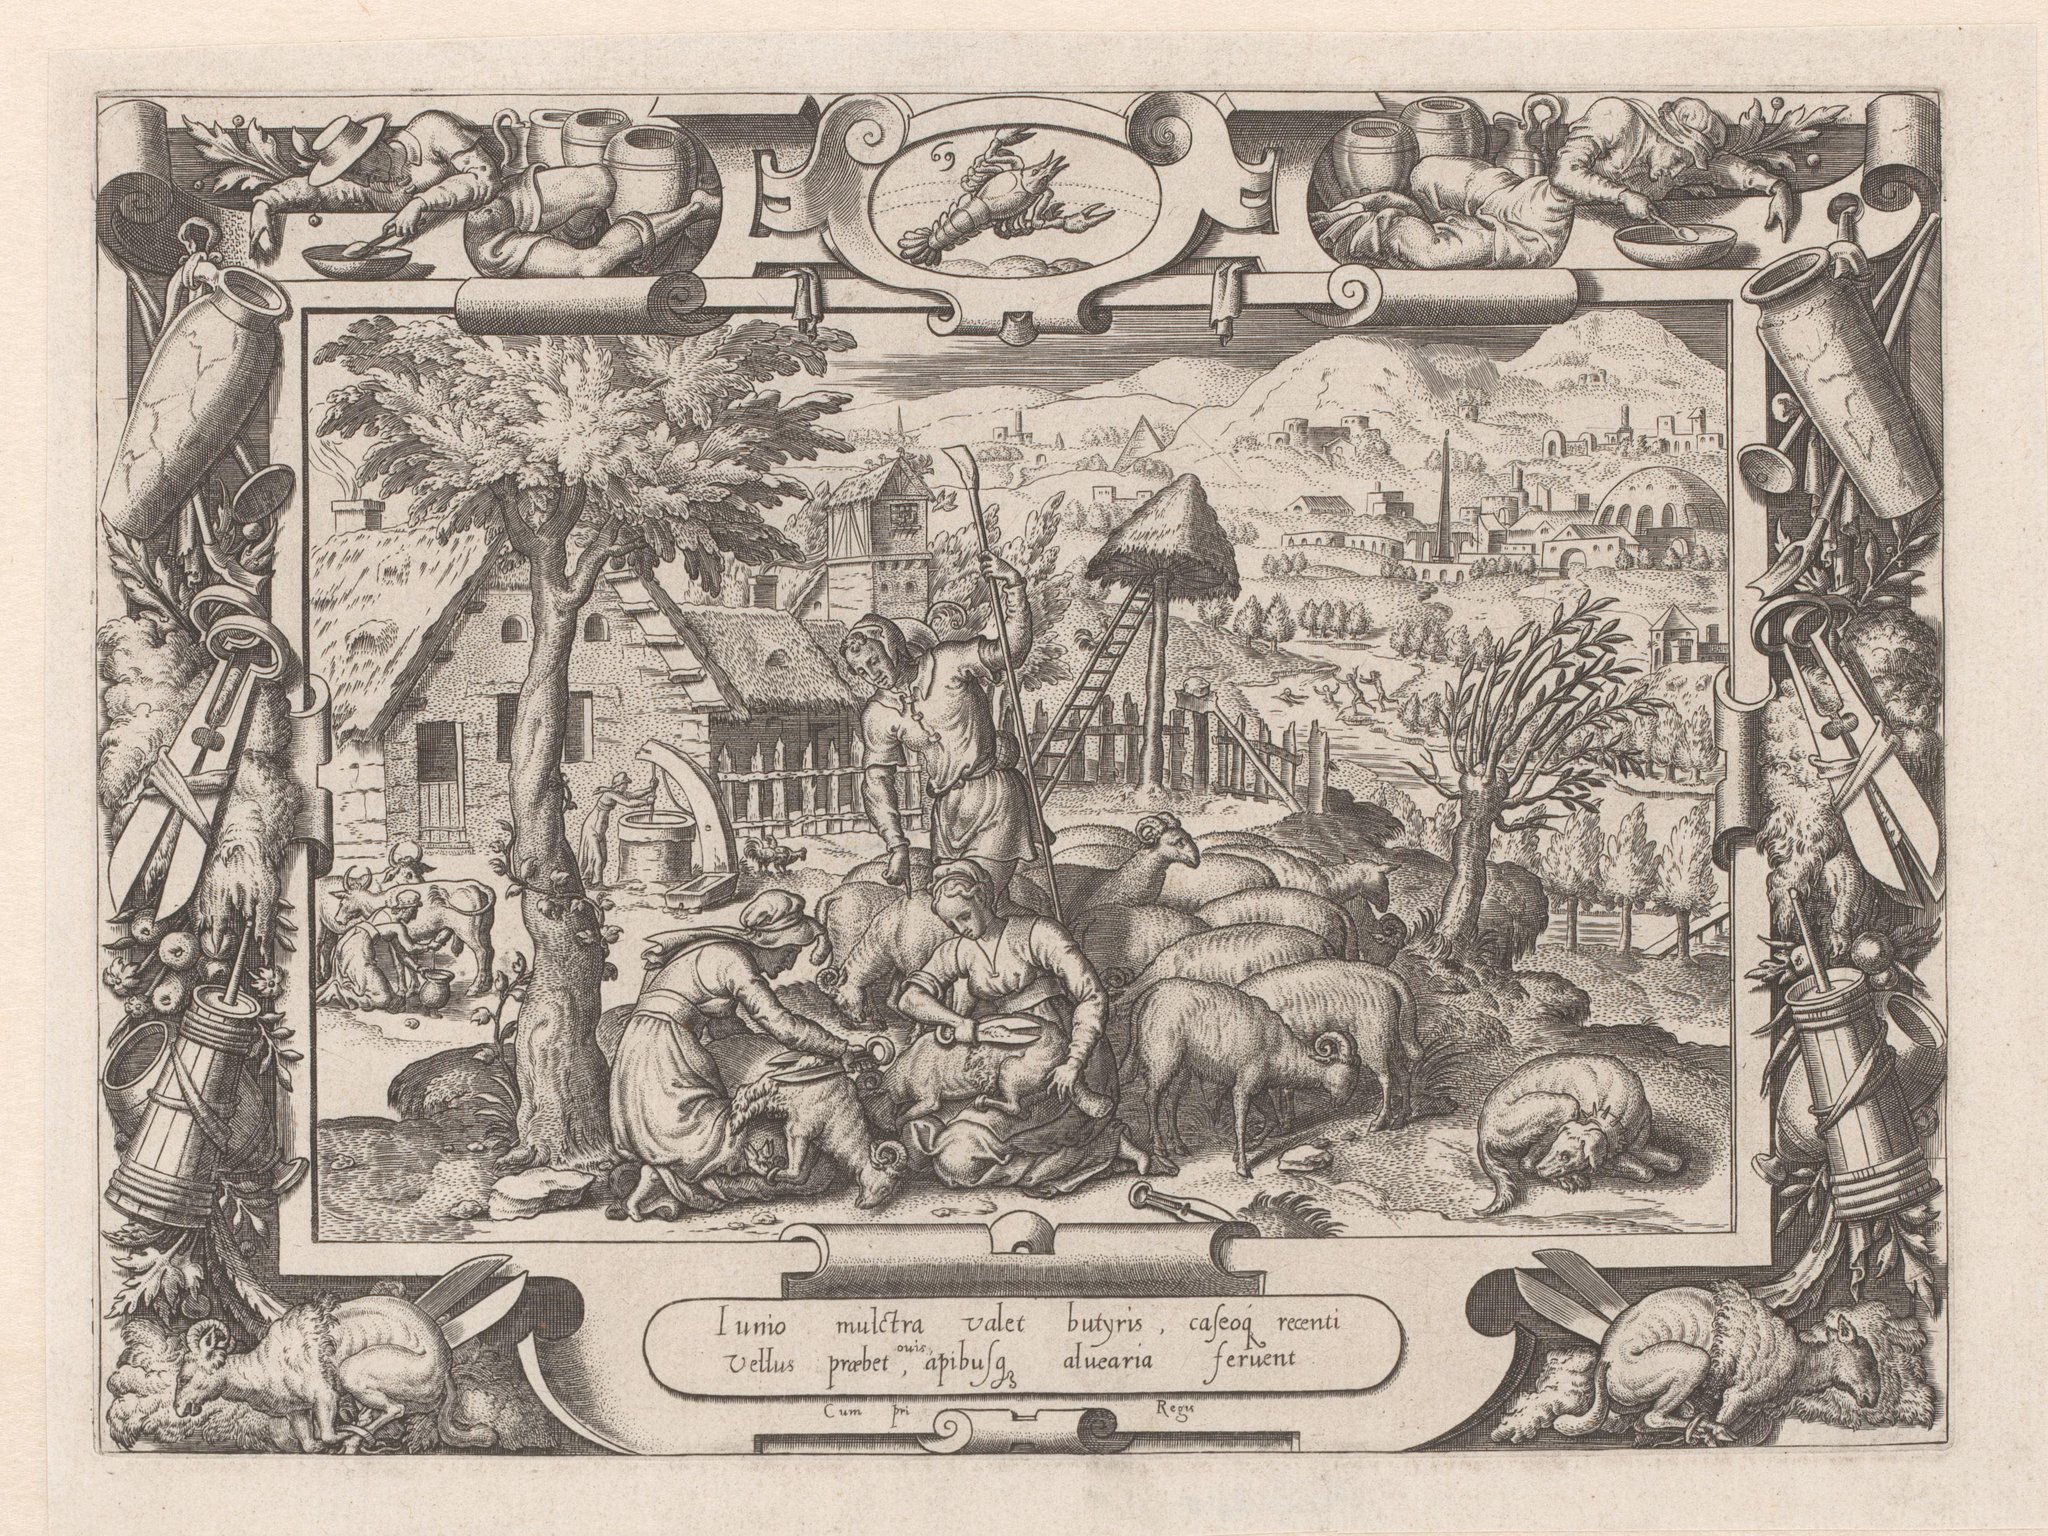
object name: print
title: Suite des Mois de l'Annee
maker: etienne delaune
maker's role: draughtsman, goldsmith, print maker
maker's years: 1519-1583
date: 1566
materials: paper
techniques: engraving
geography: france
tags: cancer (zodiacal sign of june), sheep, tools, aids, implements ~ crafts and industries: scissors, june and its 'labours' (+ with zodiacal signs), shearing (sheep), wool (material ~ textile industry)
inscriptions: collector's mark: Lugt 2228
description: Maakt deel uit van een twaalfdelige serie van de twaalf maanden in ornamentele lijsten met corresponderende motieven en tekens van de dierenriem. Januari, met het hoofd van Janus, vormt de enige uitzondering. In de collectie van het Rijksmuseum bevindt zich de complete serie.